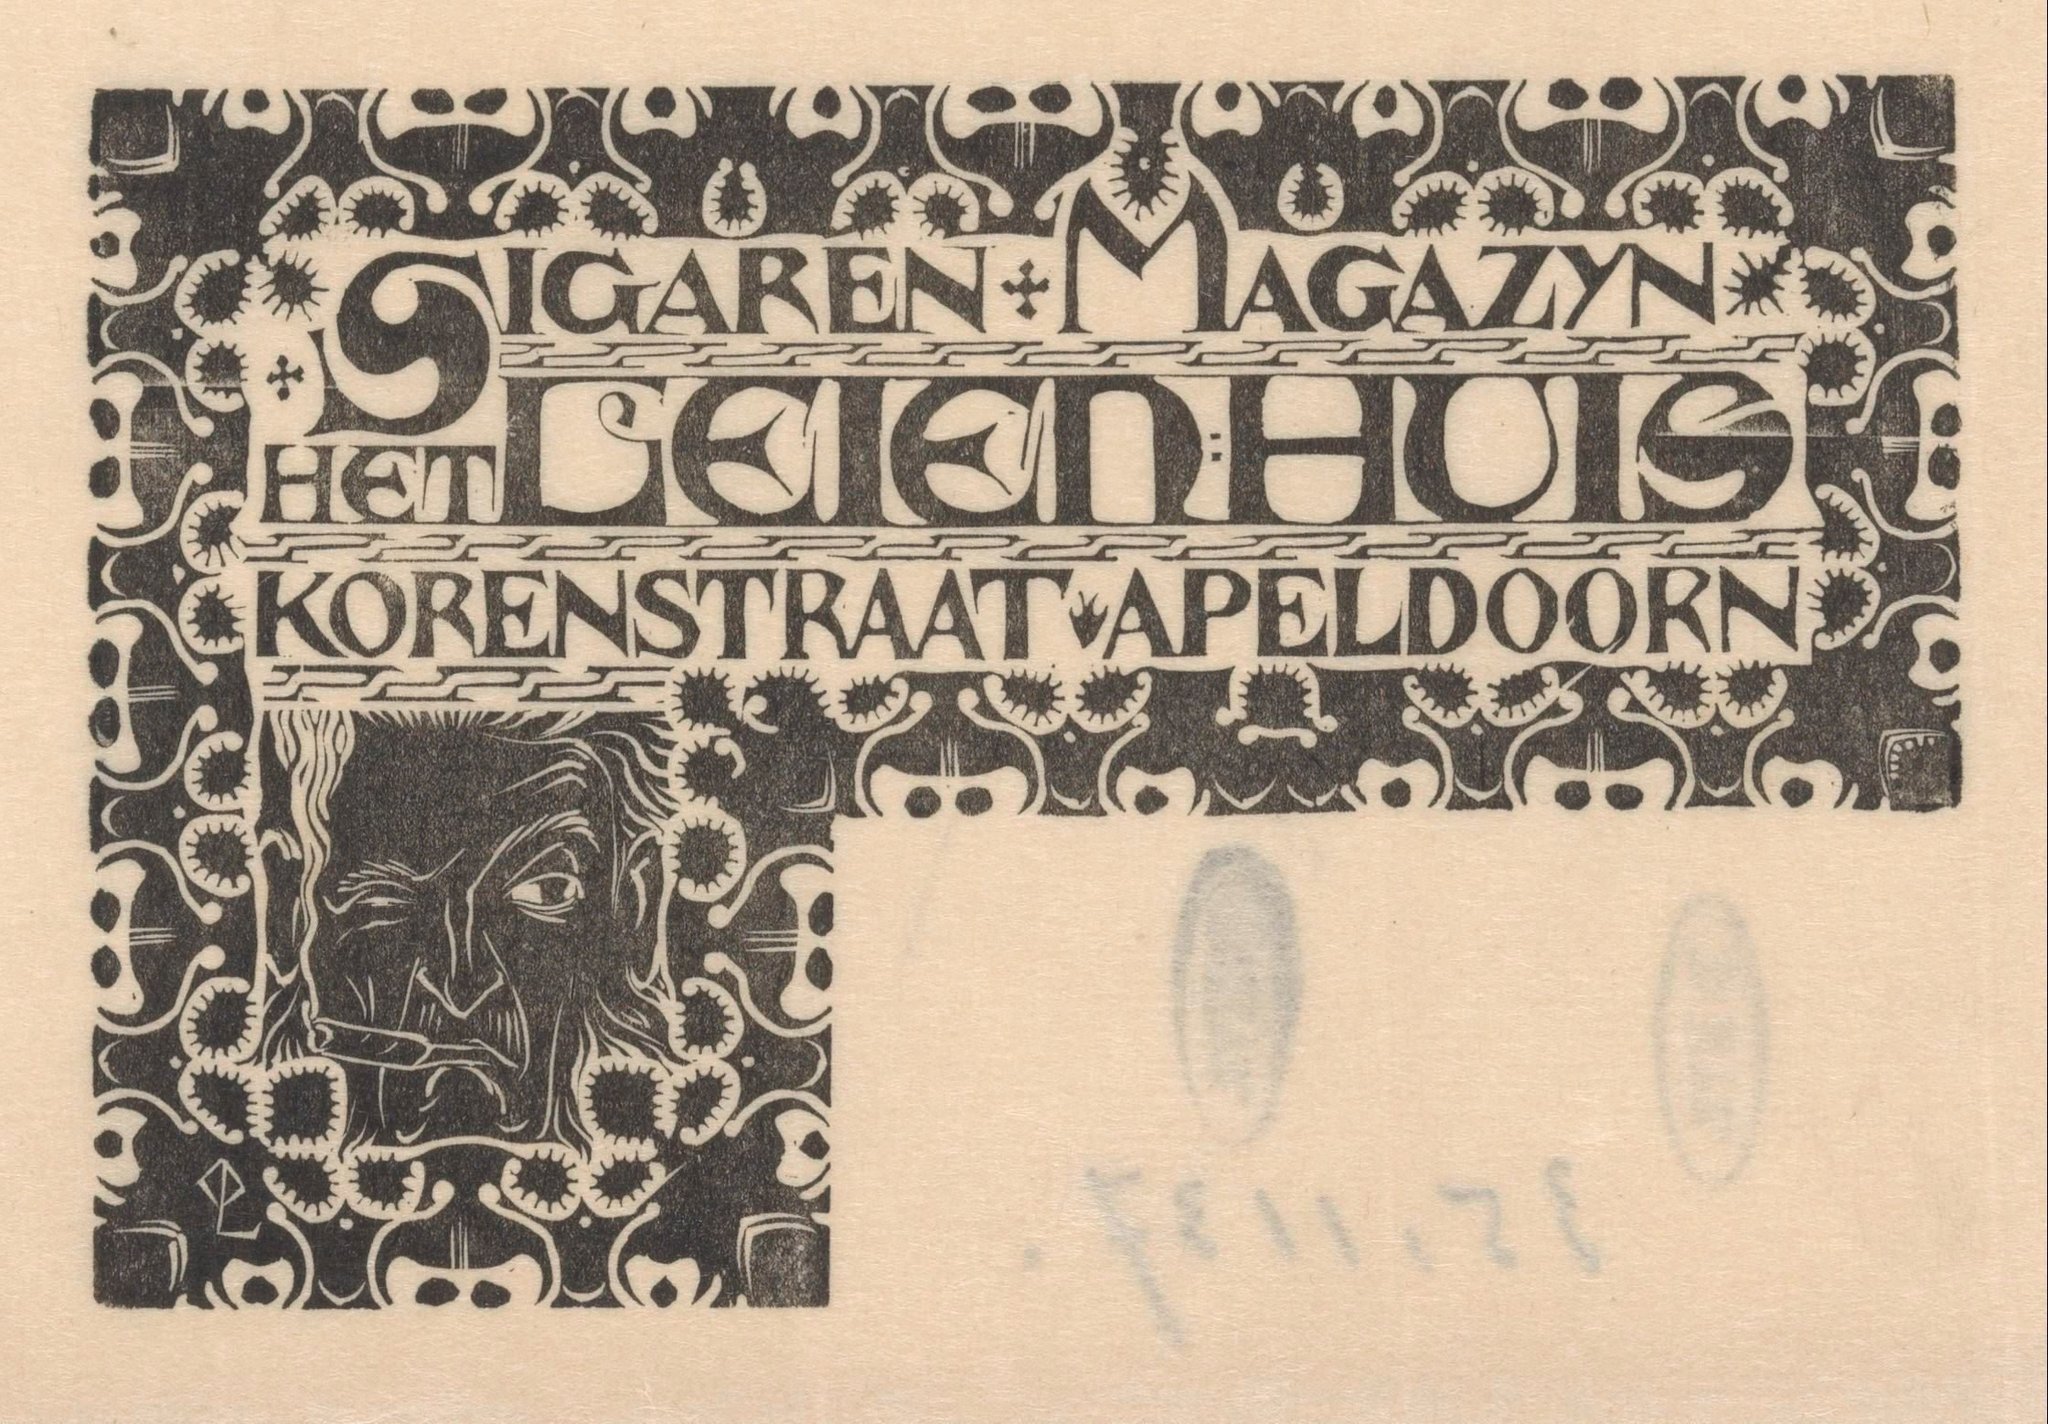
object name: advertisement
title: Advertentie van sigarenmagazijn Het Leienhuis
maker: mathieu lauweriks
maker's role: designer, draughtsman, print maker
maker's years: 1864-1932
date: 1874-1932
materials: paper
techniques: woodcut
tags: cigar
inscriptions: collector's mark: Lugt 2228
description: Advertentie van sigarenmagazijn Het Leienhuis aan de Korenstraat in Apeldoorn. Linksonder het gezicht van een knipogende man met een sigaar in zijn mond.